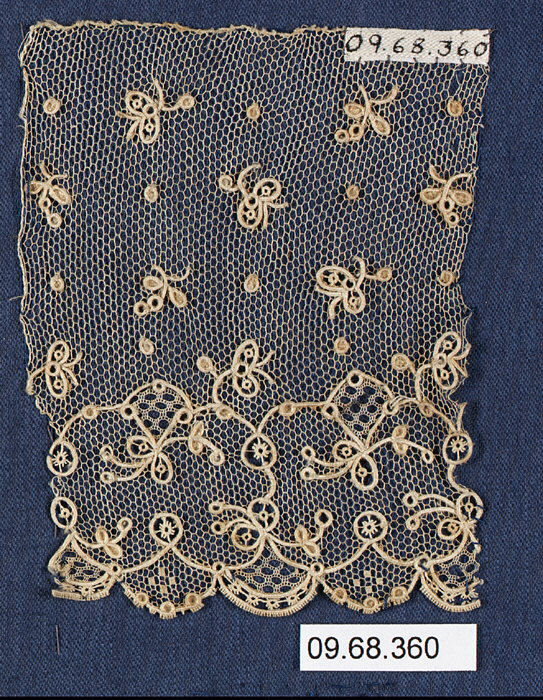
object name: fragment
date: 1801-1900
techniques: lace